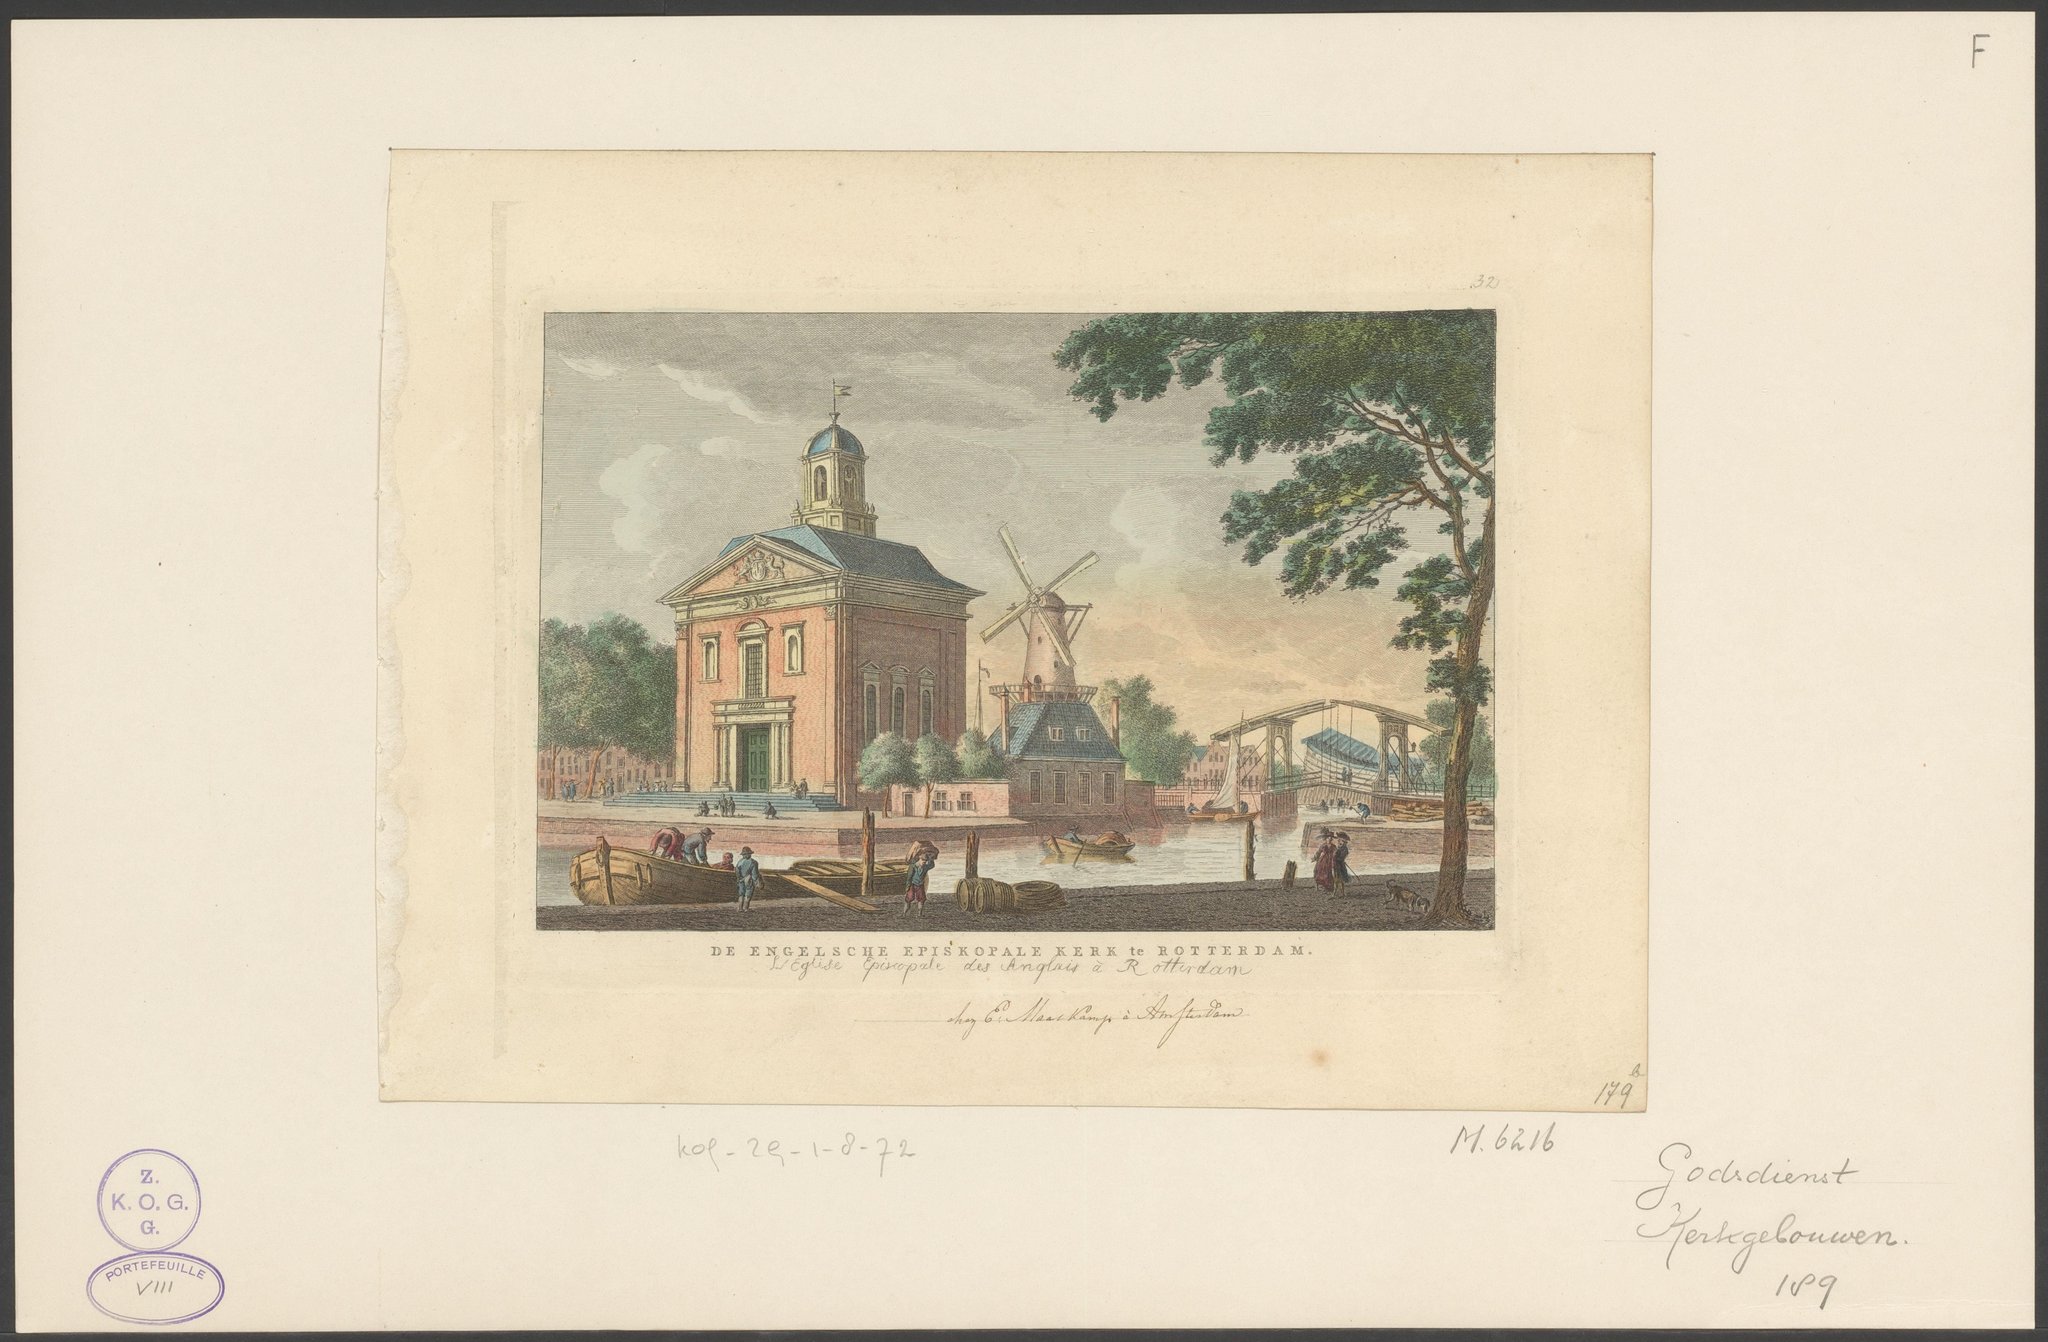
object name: print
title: De Engelsche Episkopale kerk te Rotterdam / L'Eglise Episcopale des Anglais à Rotterdam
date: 1786-1792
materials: paper, watercolor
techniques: engraving, etching, hand coloring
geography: amsterdam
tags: church (exterior), rowing-boat, canoe, etc., bridge in city across river, canal, etc., windmill, rotterdam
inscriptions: collector's mark, collector's mark: Lugt 1641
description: Huidige staat van prent uitgegeven als onderdeel van een plaatwerk uit ca. 1824-1825 met 74 (ongenummerde) platen van de belangrijkste topografische gezichten en verschillende zeden en gewoonten in het Verenigd Koninkrijk der Nederlanden, getiteld 'Tableau des principales vues des palais et édifices : représentations et des coutumes et usages, dans les provinces septentrionales du Royaume des Pays-Bas'. Eerdere staat gebruikt in: Vaderlandsche gezichten, of afbeeldingen van den tegenwoordigen staat der Vereenigde Nederlanden (…). Amsterdam: Hendrik Gartman, Willem Vermandel en Jan Willem Smit, 1786-1792. Uitgegeven in afleveringen met ieder een eigen bifolium en inhoudsopgave. Alle prenten in deze publicatie zijn gegraveerd door Carel Frederik Bendorp (I) en, in de meeste gevallen, gebaseerd op tekeningen van Jan Bulthuis.